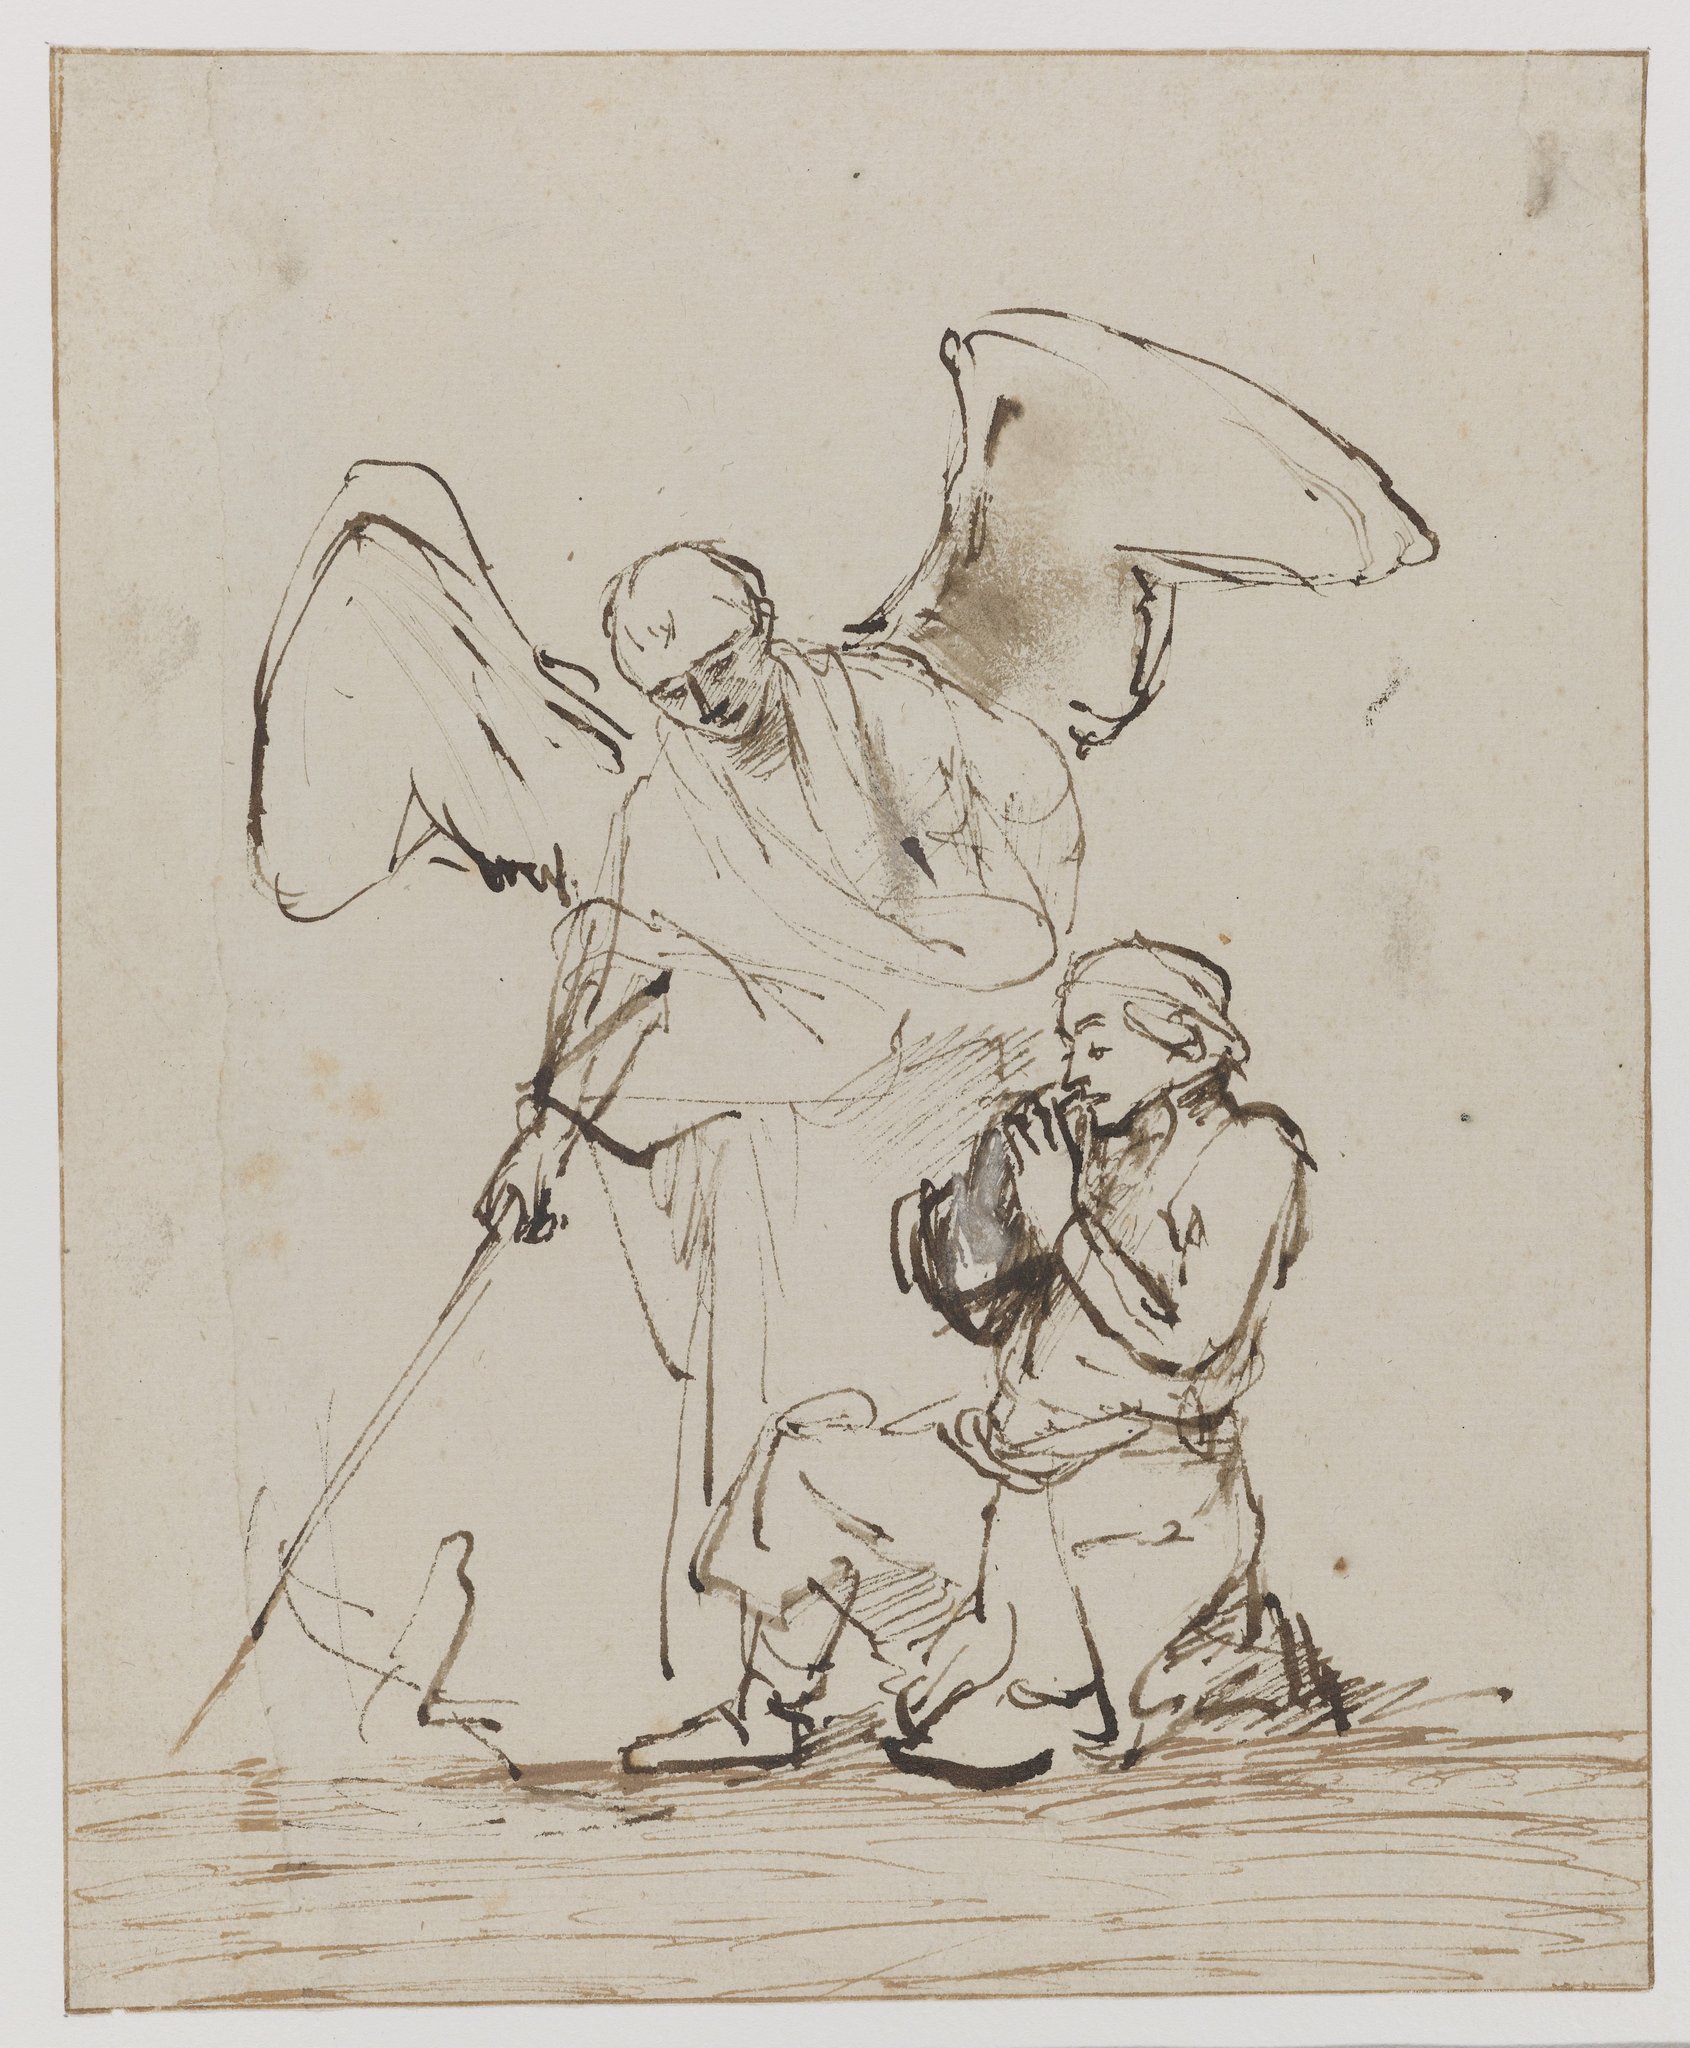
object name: drawing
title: Tobias and the Angel with the Fish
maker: willem drost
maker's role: draughtsman, painter, print maker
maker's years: 1633-1659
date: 1650-1655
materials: paint, ink, paper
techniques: pen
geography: amsterdam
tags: tobias and the angel raphael travelling, accompanied by tobias' dog